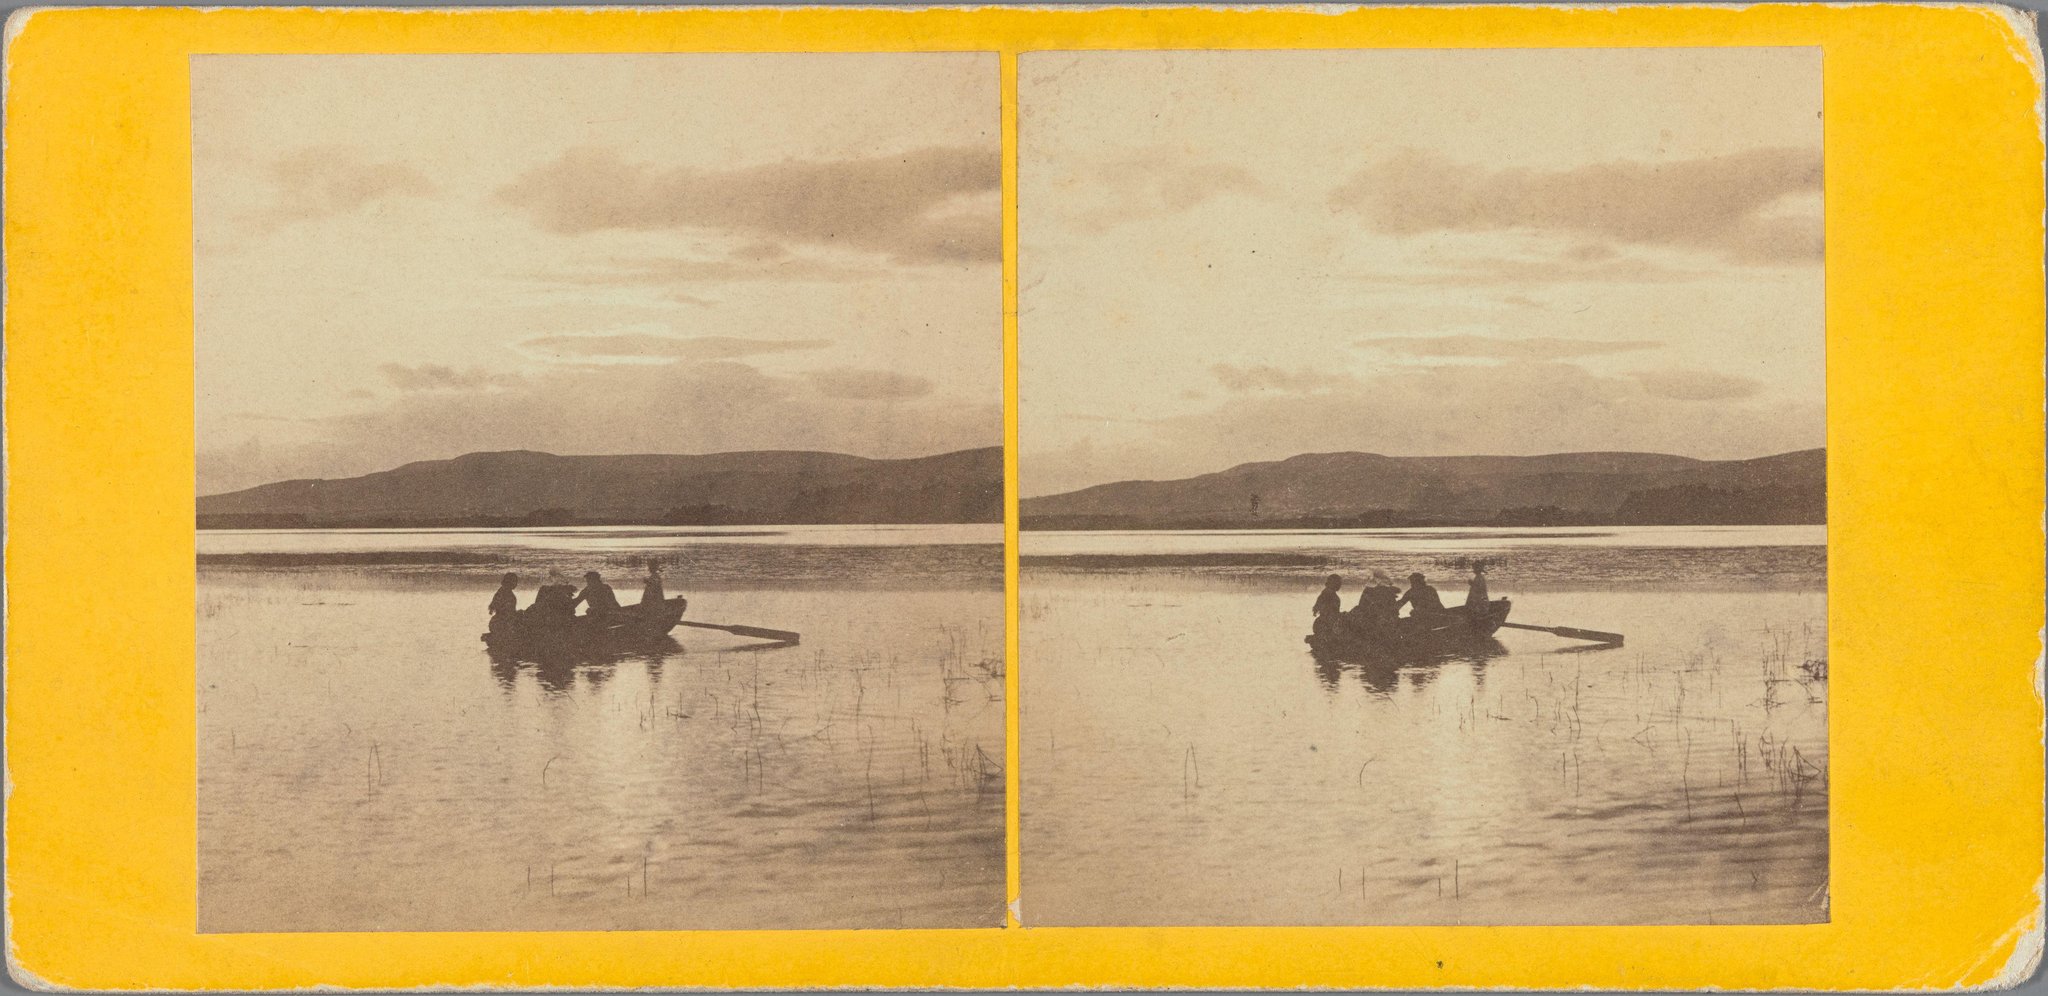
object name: stereograph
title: Gezelschap in een roeiboot op het Loch of Park in Aberdeenshire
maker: george washington wilson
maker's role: publisher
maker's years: 1823-1893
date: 1859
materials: cardboard, paper, photographic support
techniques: albumen print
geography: aberdeenshire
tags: rowing-boat, canoe, etc., lake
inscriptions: inscription: ‘Loch of Park, Aberdeenshire (Instantaneous) No. 283.’